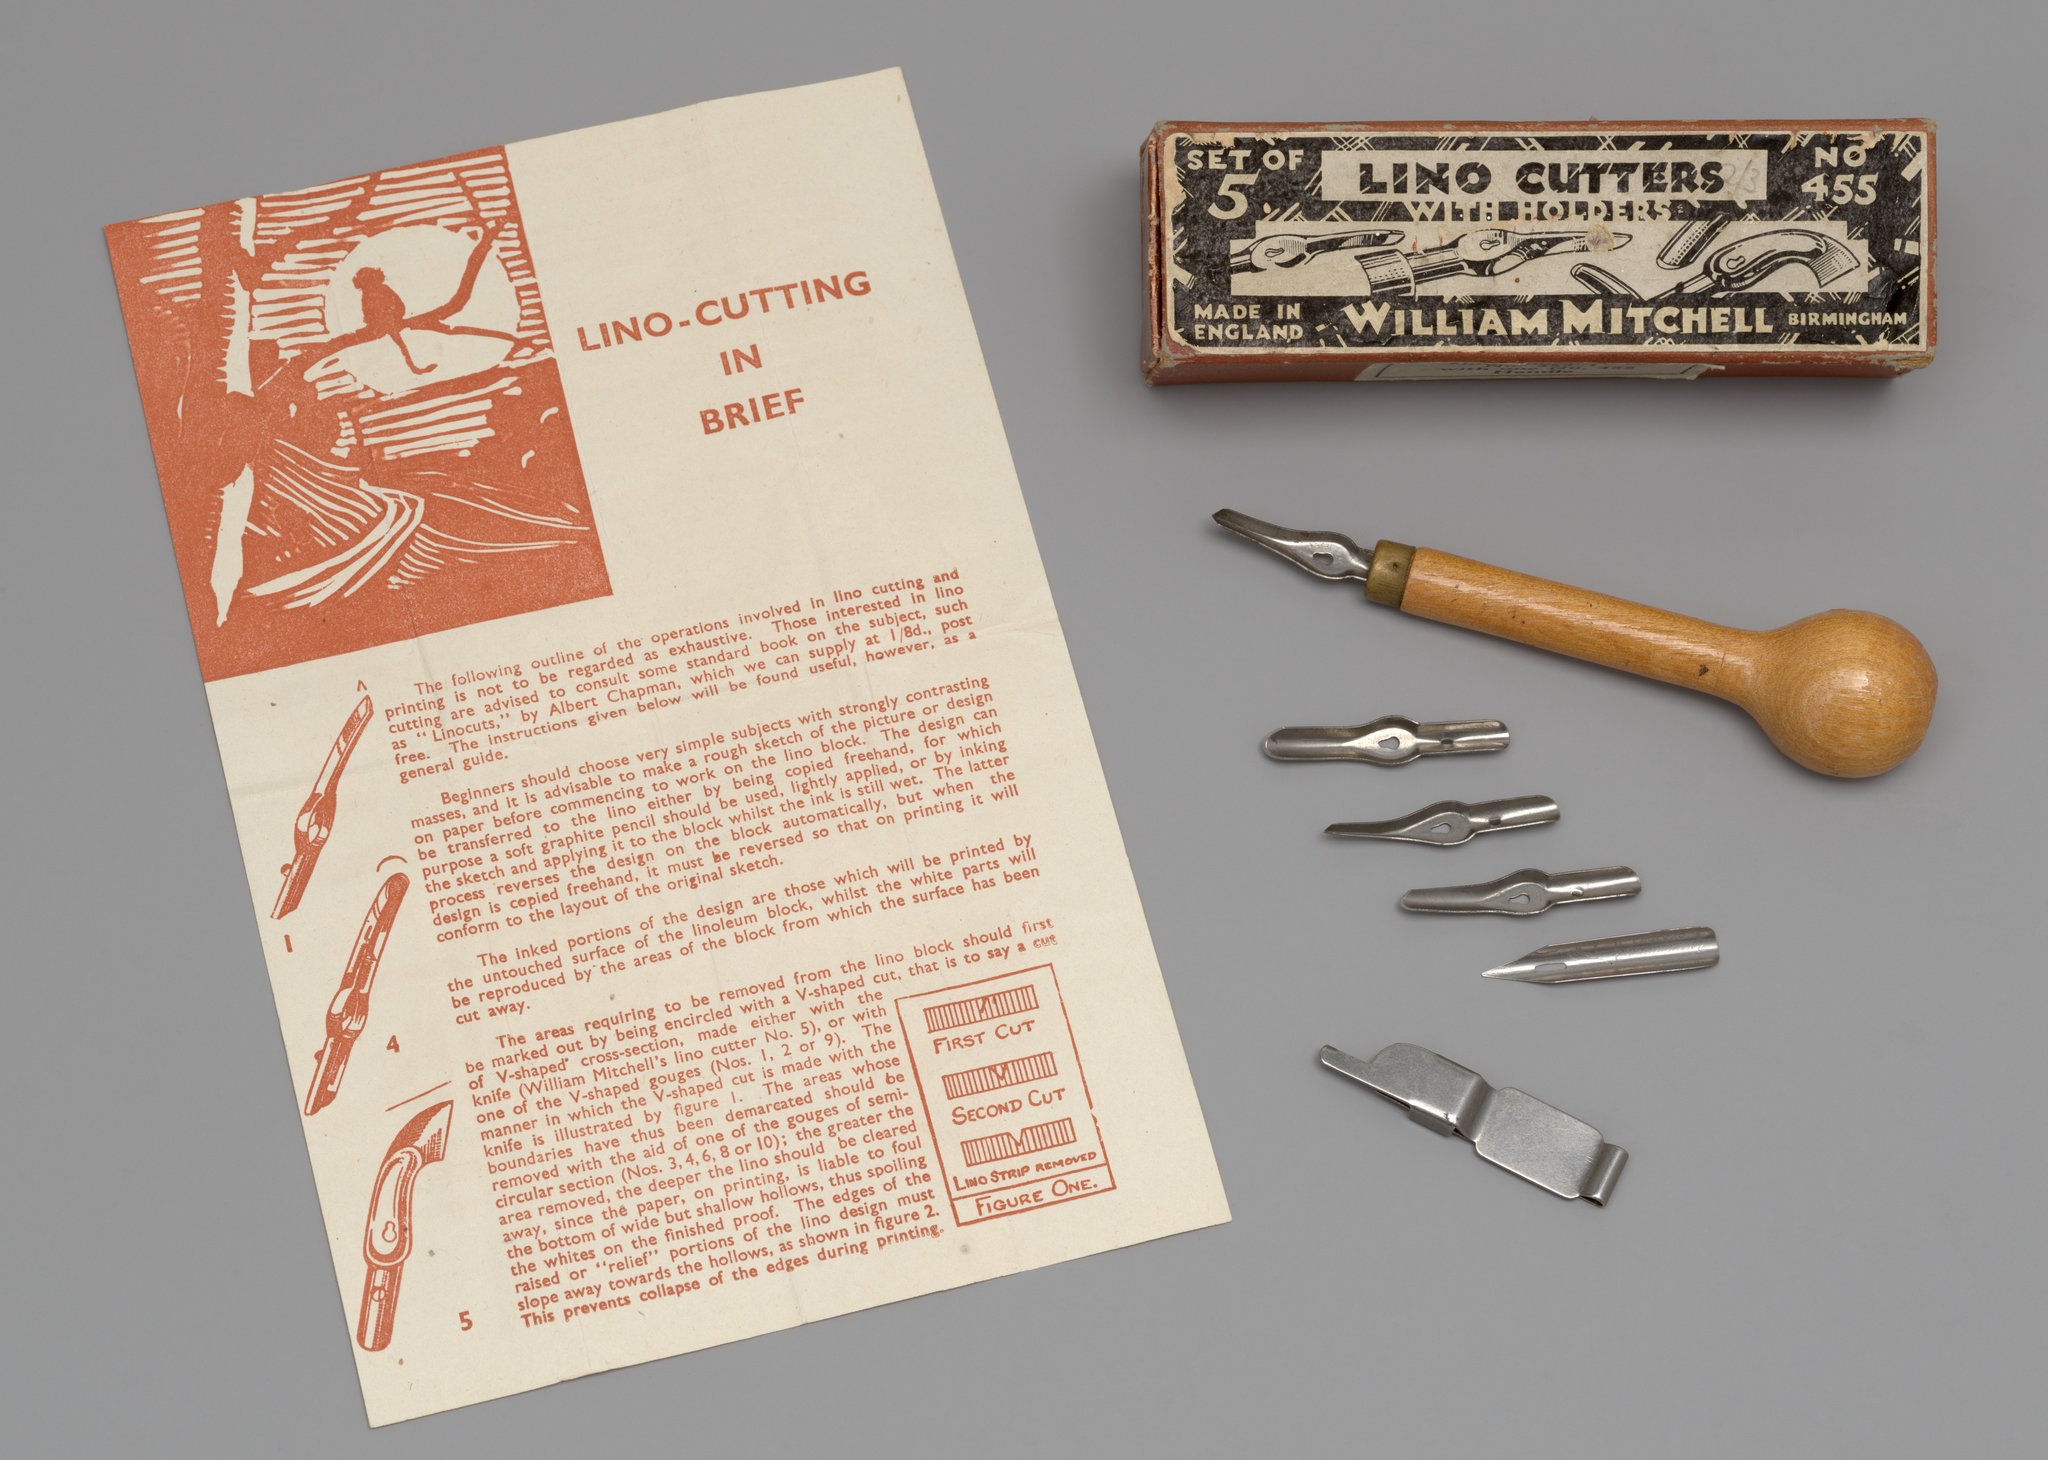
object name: tool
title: Tools accompanying The Art and Craft of Lino Cutting and Printing by Claude Flight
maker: claude flight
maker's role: artist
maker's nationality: british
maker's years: 1881-1955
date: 1934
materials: paper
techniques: printing